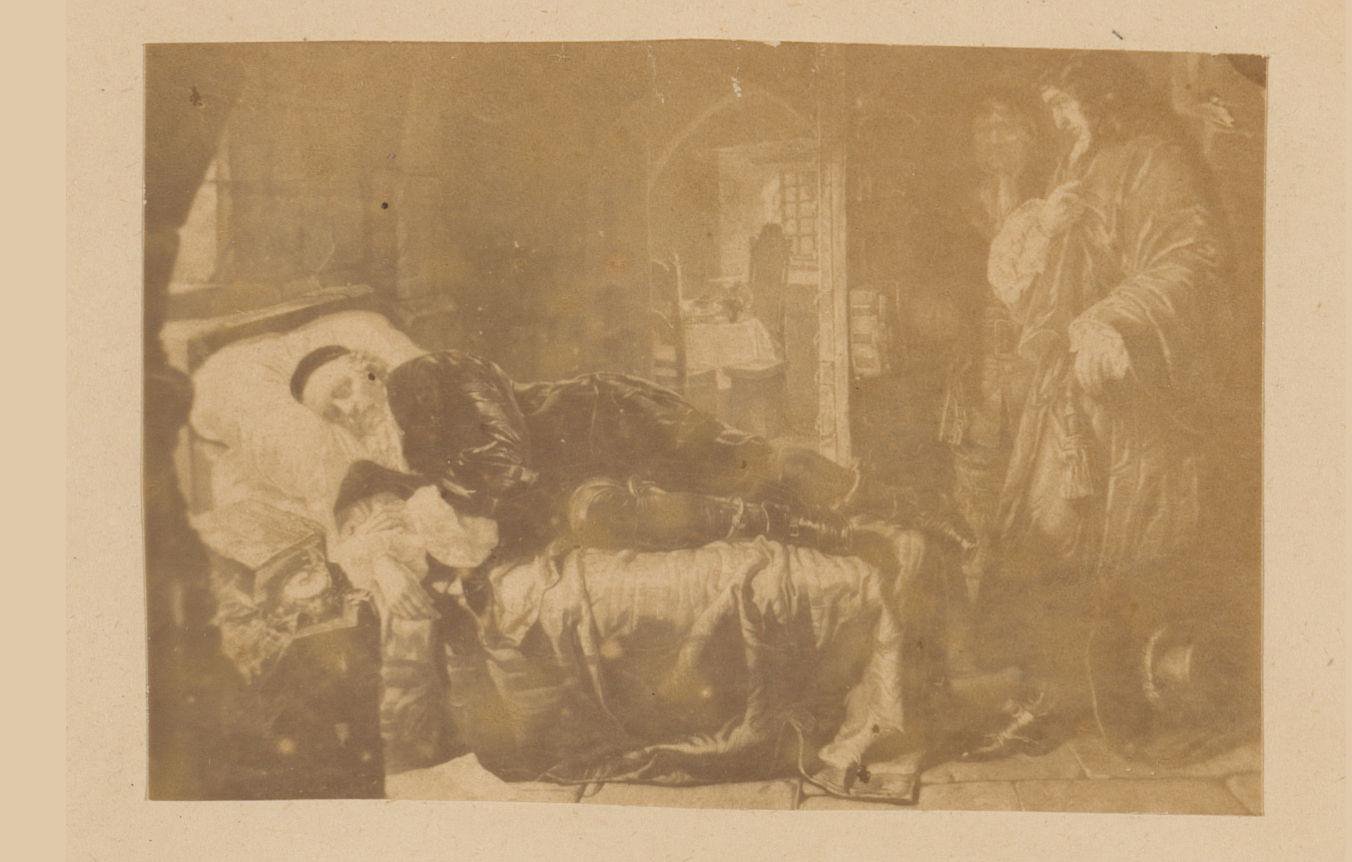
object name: reproduction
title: Fotoreproductie van een schilderij met een slapende man op bed en twee staande mannen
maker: Anonymous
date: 1875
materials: paper, photographic support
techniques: albumen print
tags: sleeping in bed